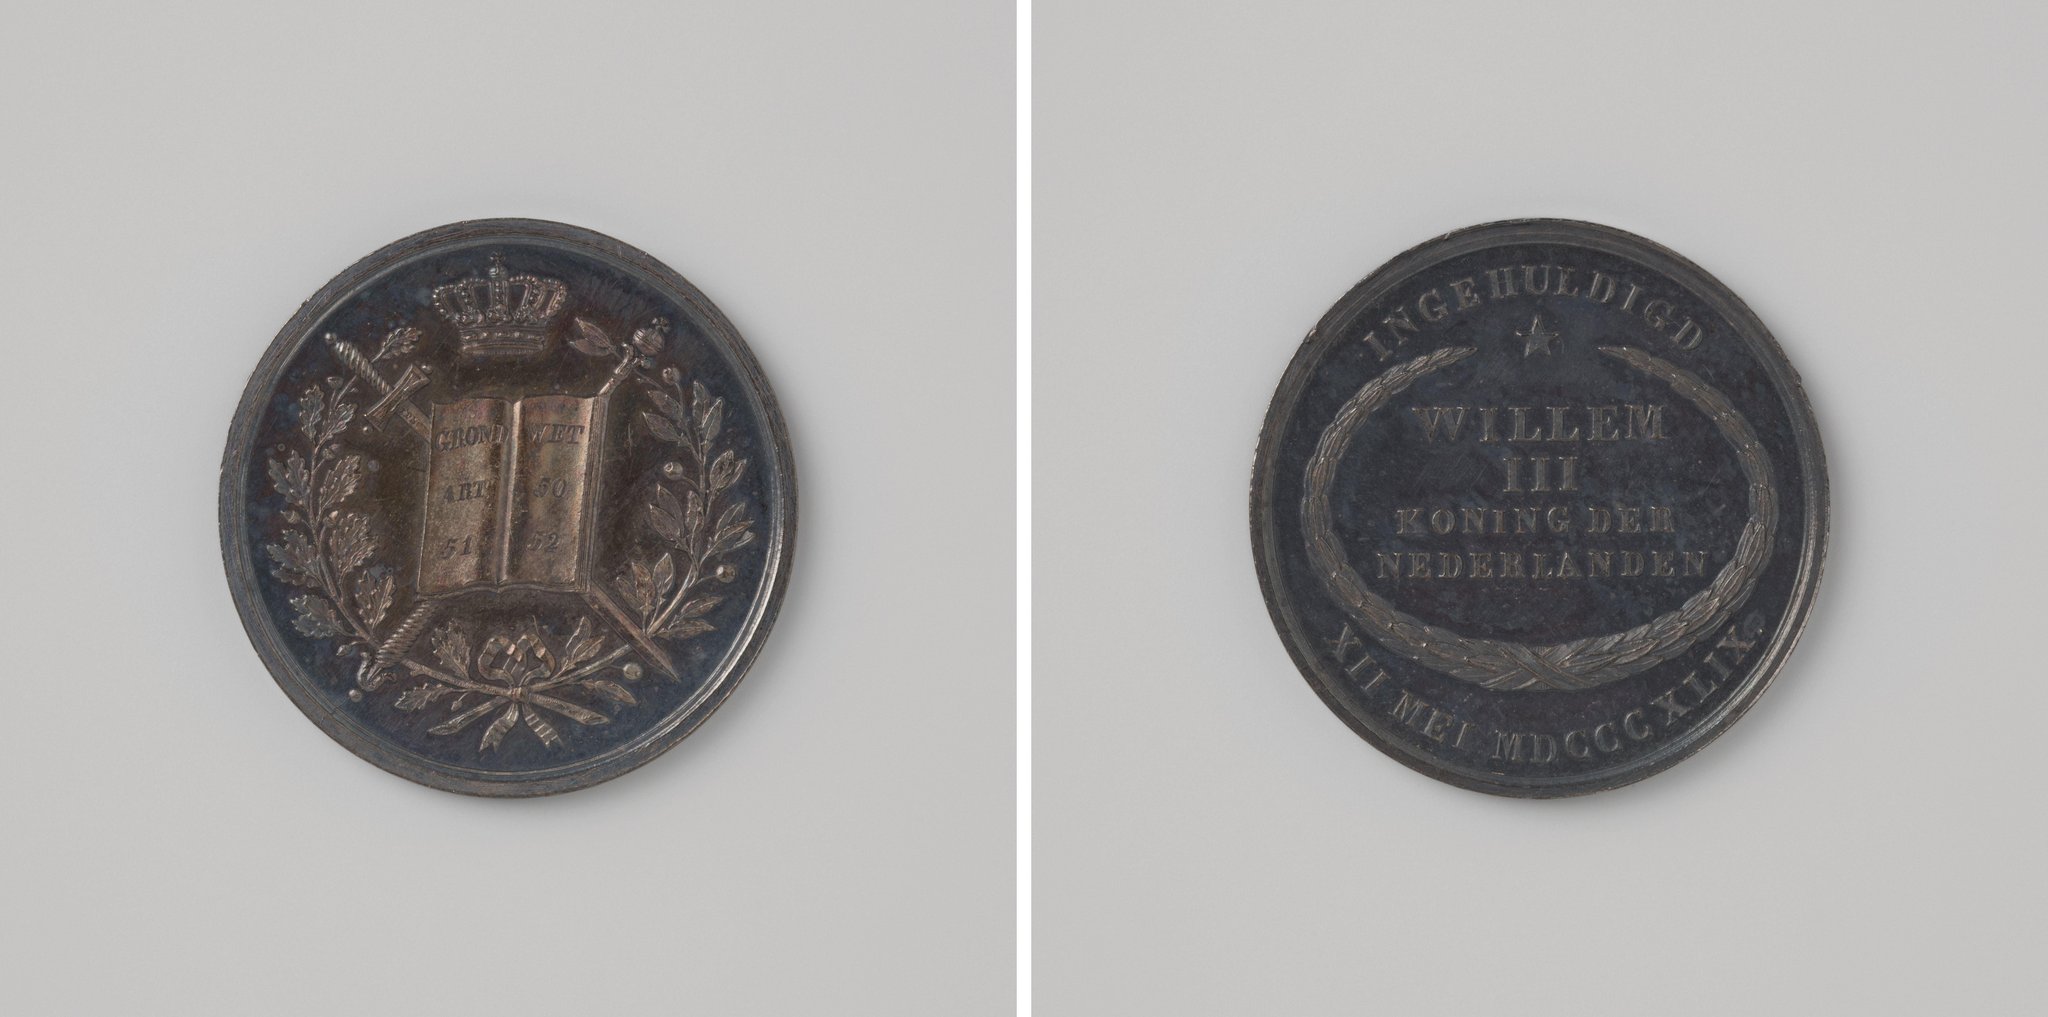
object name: history medal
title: Strooipenning bij de inhuldiging van Koning Willem III te Amsterdam 1849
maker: johannis petrus schouberg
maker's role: die cutter, draughtsman, print maker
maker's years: 1798-1864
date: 1849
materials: silver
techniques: striking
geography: utrecht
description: Zilveren penning, op de voorzijde het boek der grondwet op gekruisd zwaard en scepter onder een kroon tussen een samengestrikte eiken- en lauwertak, op de keerzijde vier regels tekst binnen een lauwerdiadeem, met omschrift.